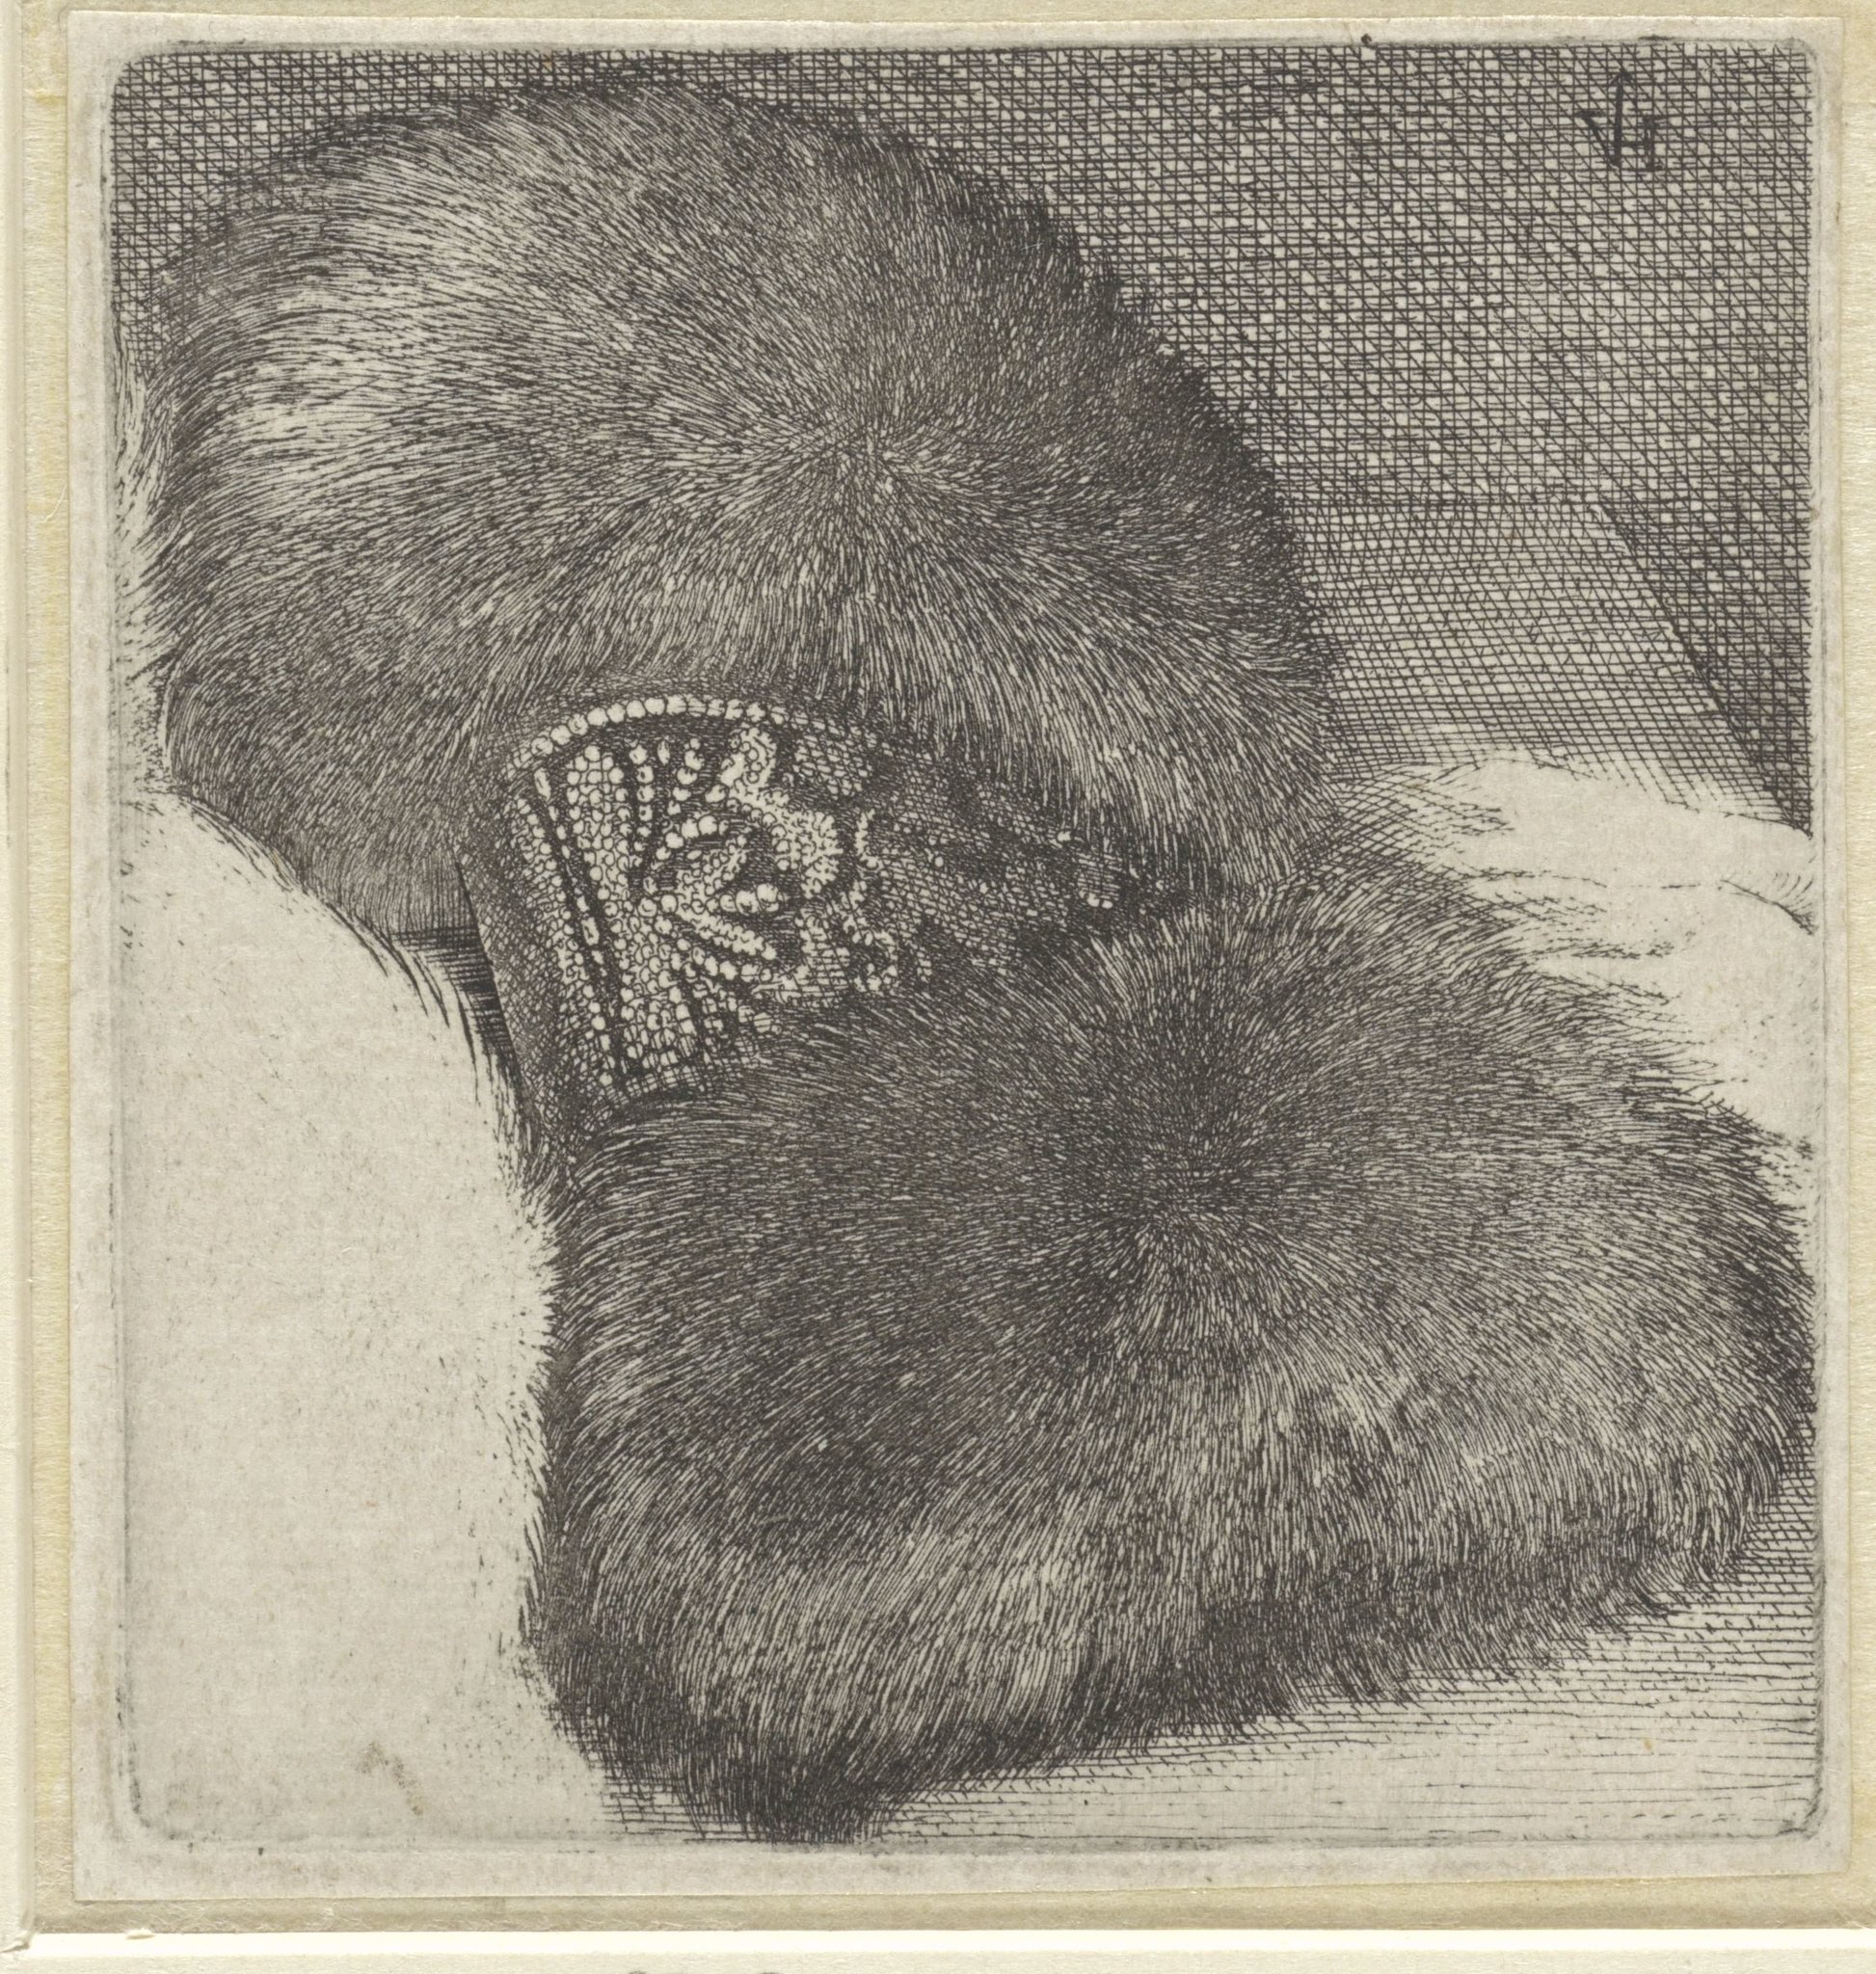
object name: print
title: Moffen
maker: wenceslaus hollar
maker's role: draughtsman, print maker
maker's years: 1607-1677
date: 1645-1647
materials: paper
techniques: etching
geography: antwerp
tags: border, ribbon, braid, muff (+ fur used for clothes)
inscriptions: collector's mark: Lugt 240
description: De prent maakt deel uit van een zesdelige serie met afbeeldingen van verschillende moffen.